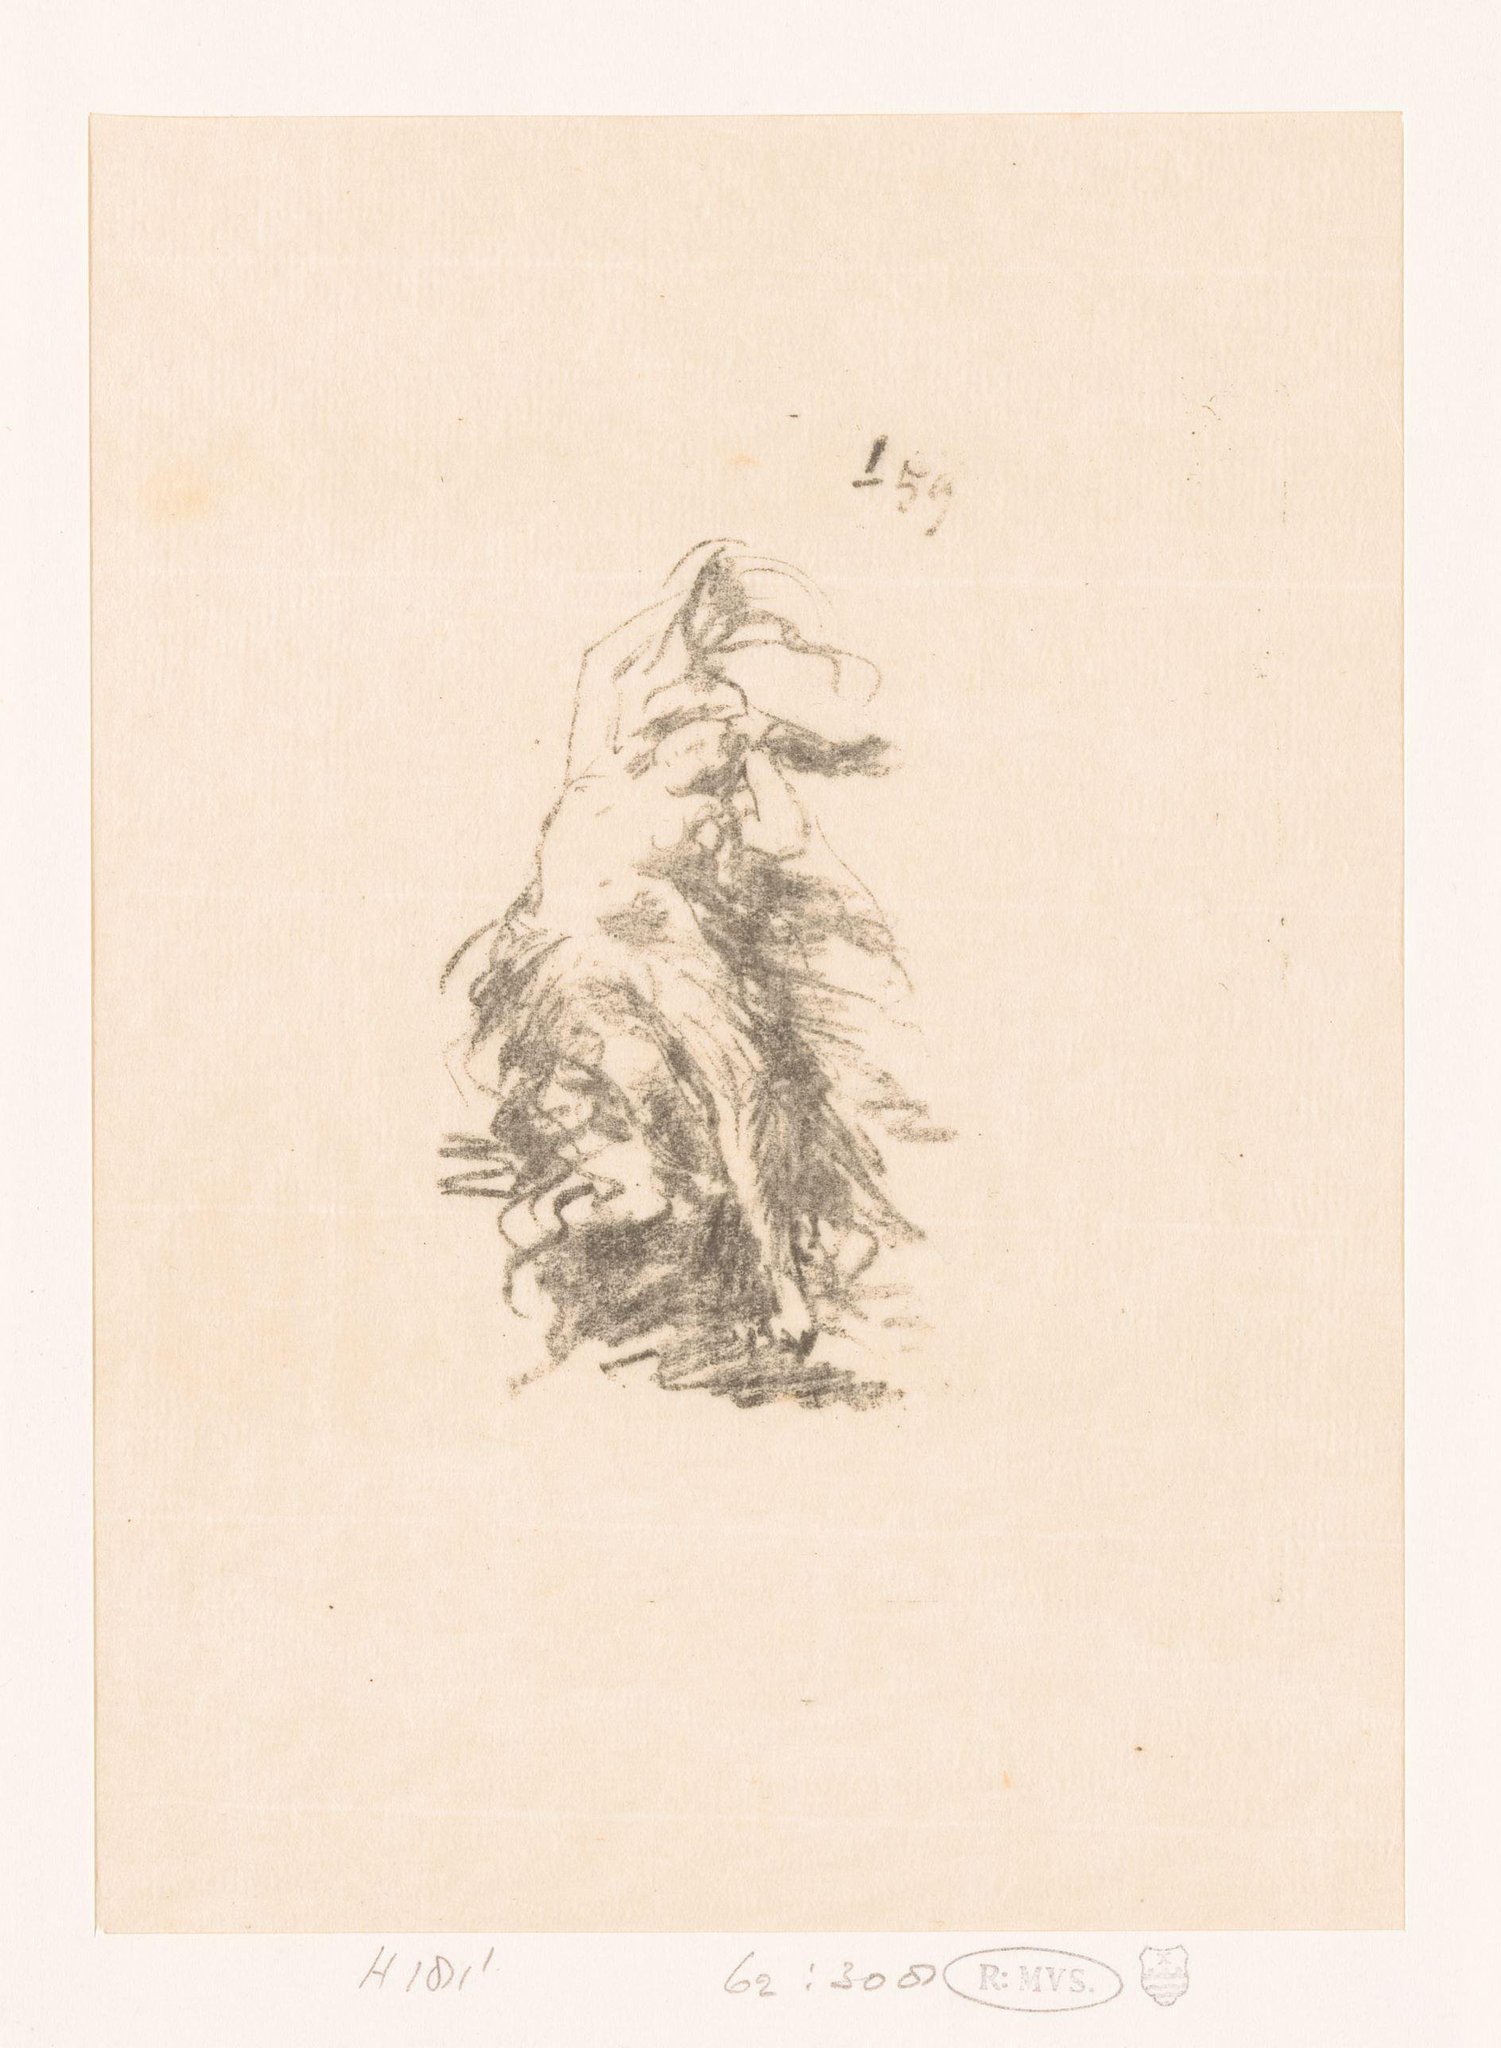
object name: print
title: Studie van een dansende vrouw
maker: henri fantin-latour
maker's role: draughtsman, print maker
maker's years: 1836-1904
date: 1903-1904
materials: paper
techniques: lithography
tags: woman dancing alone, woman (showing herself) undressed, quasi-nude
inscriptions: annotation: ‘159’, collector's mark: Lugt 2228a, collector's mark: Lugt 2760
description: Het blad is een fragment van de hele prent.